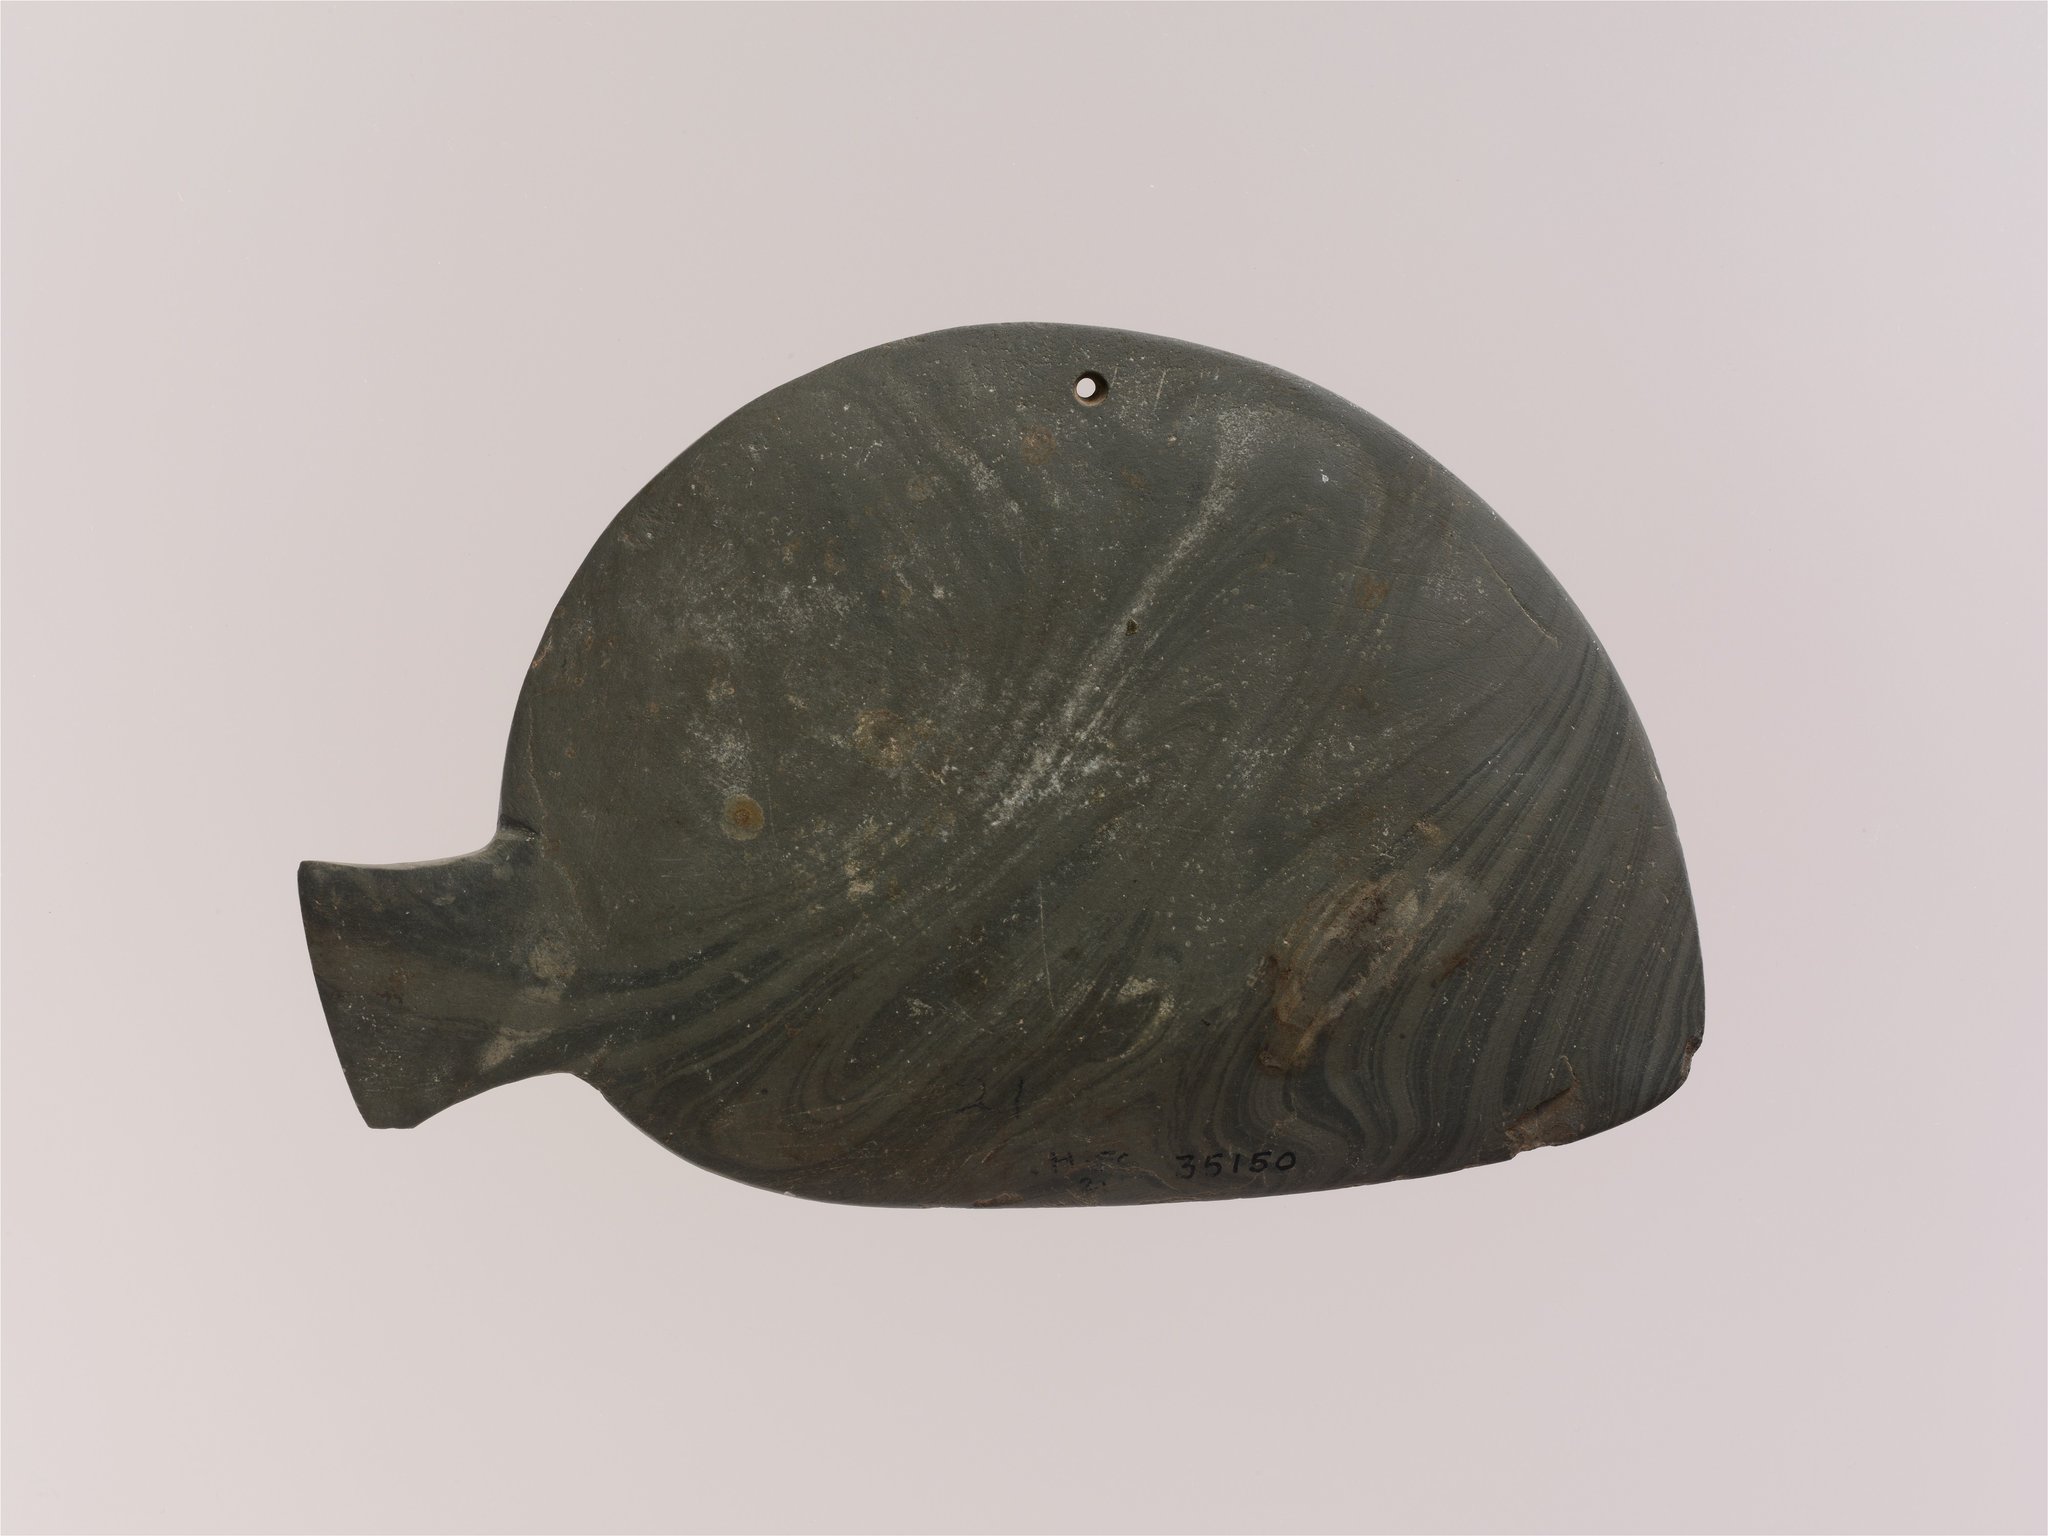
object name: palette, fish shaped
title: Fish-shaped palette with the remains of green pigment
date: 3650-3300 BCE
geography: egypt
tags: fish